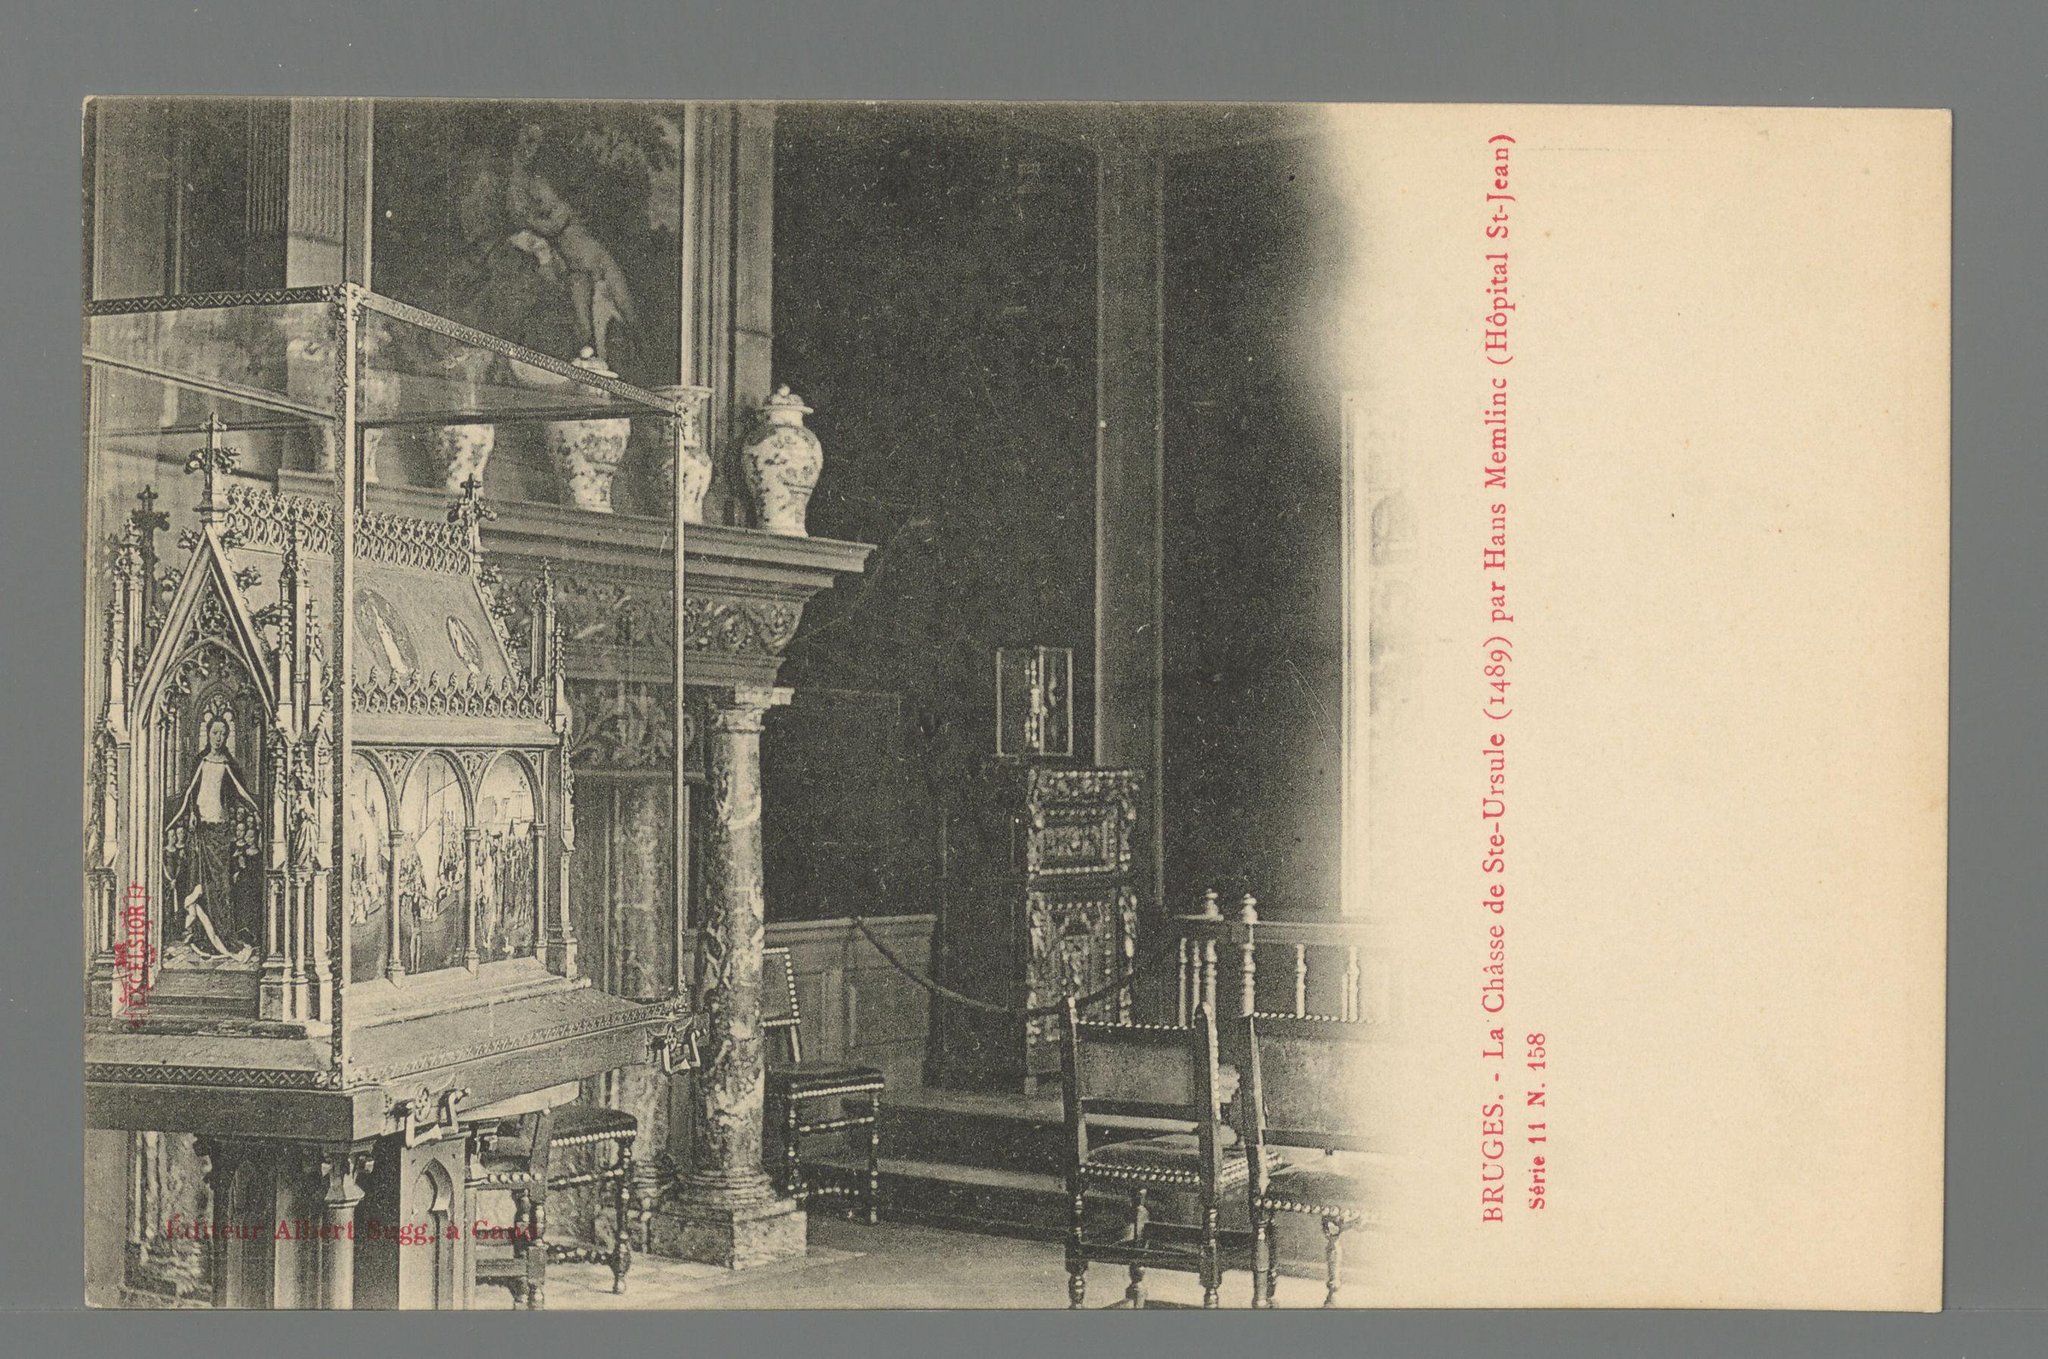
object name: photomechanical print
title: Bruges. La Châsse de Ste. Ursule (1489) par Hans Memlinc (Hôpital St. Jean)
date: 1896-1906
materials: cardboard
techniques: photograph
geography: bruges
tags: (veneration of) devotional objects, interior ~ representation of a building